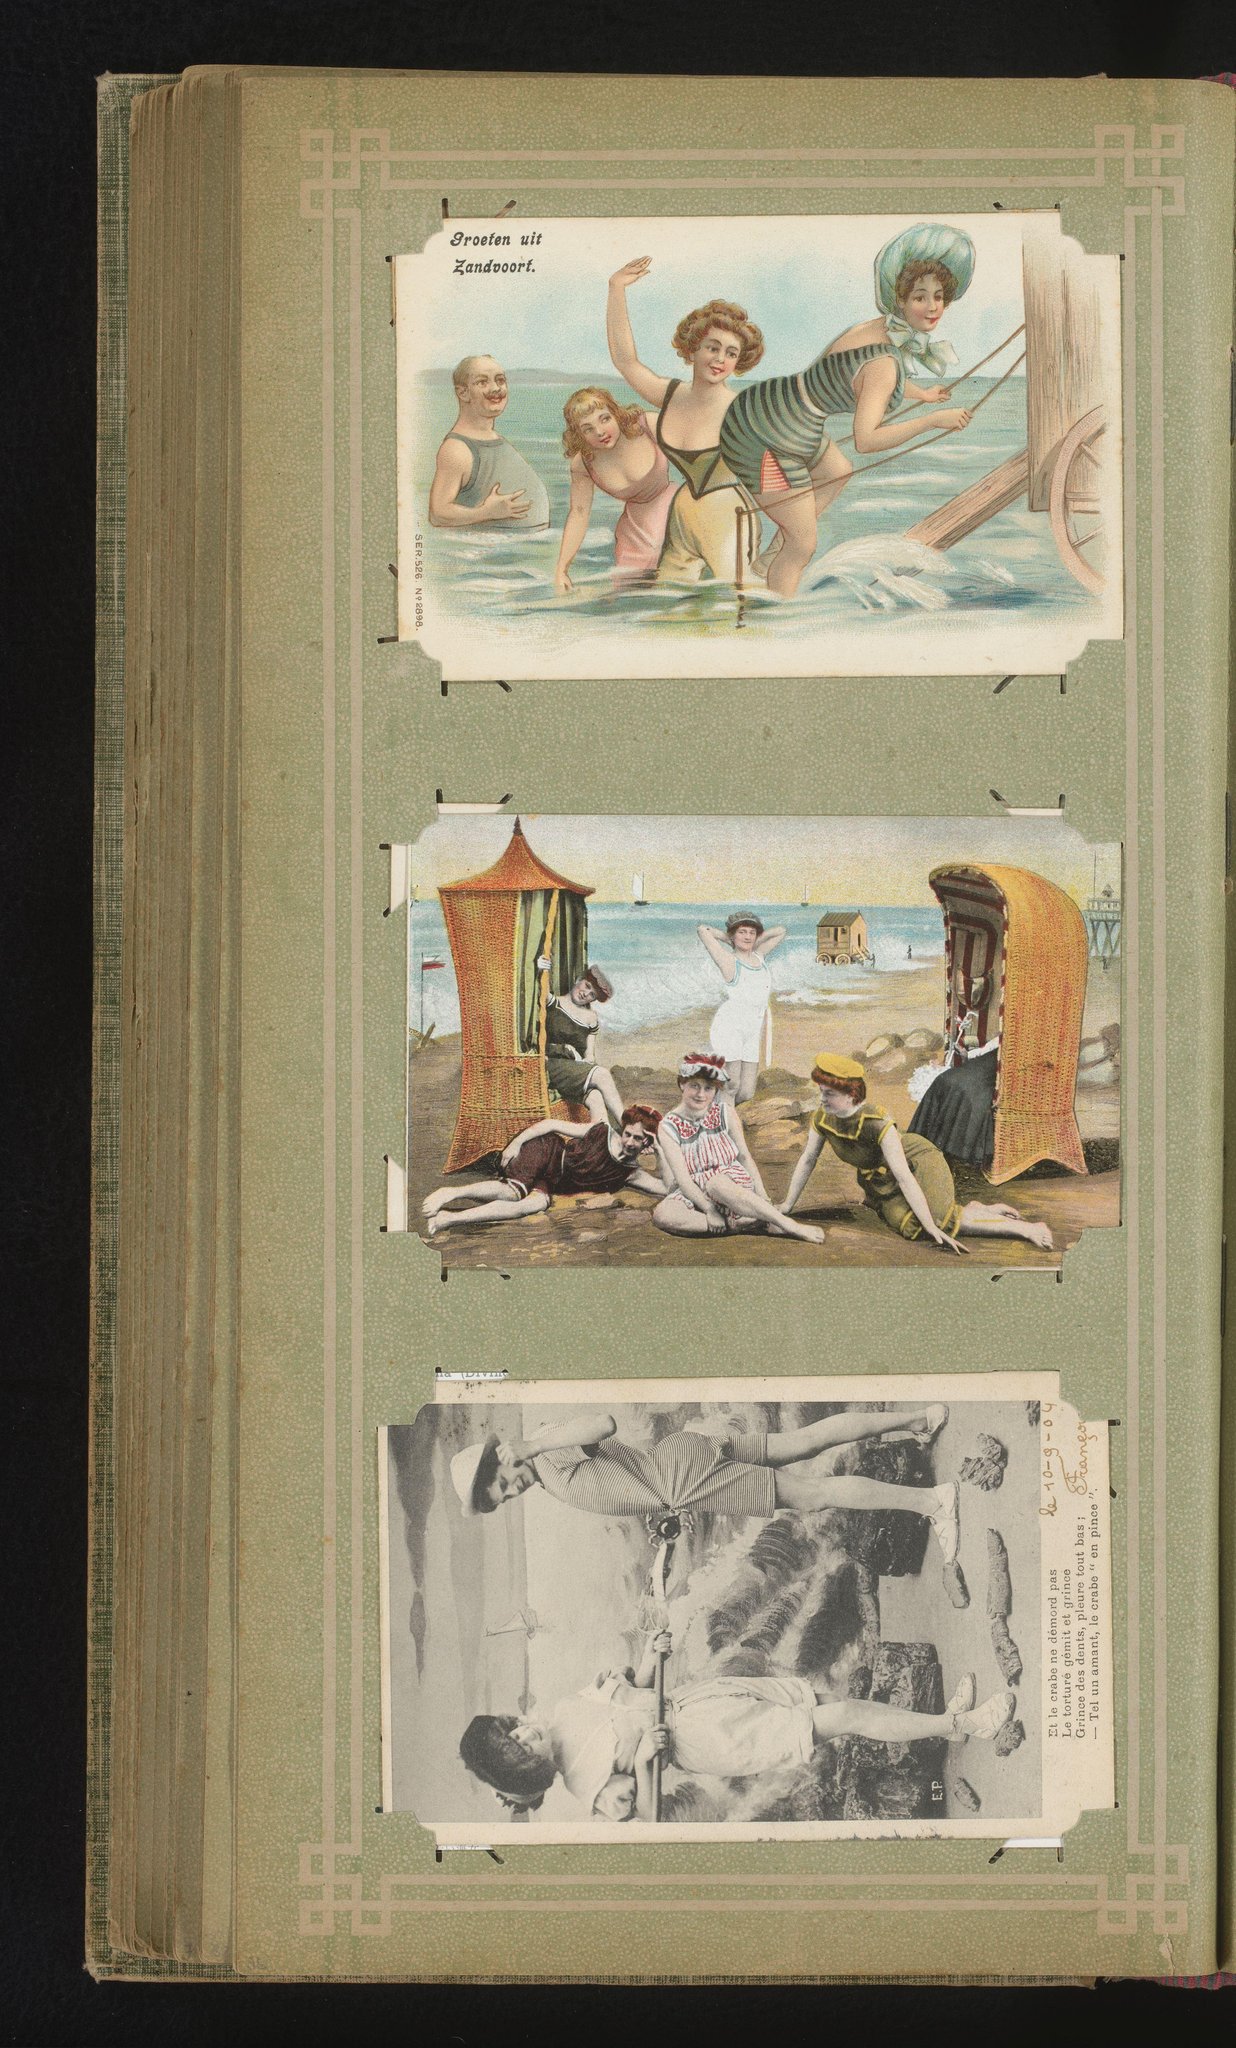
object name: ansichtkaart, prentbriefkaart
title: Drie strandscènes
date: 1900-1930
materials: cardboard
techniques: chromolithography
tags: historical persons - bb - woman, swimming (movement in water), beach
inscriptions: monogram: ‘E.P.’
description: Deze prenten maken deel uit van een album.